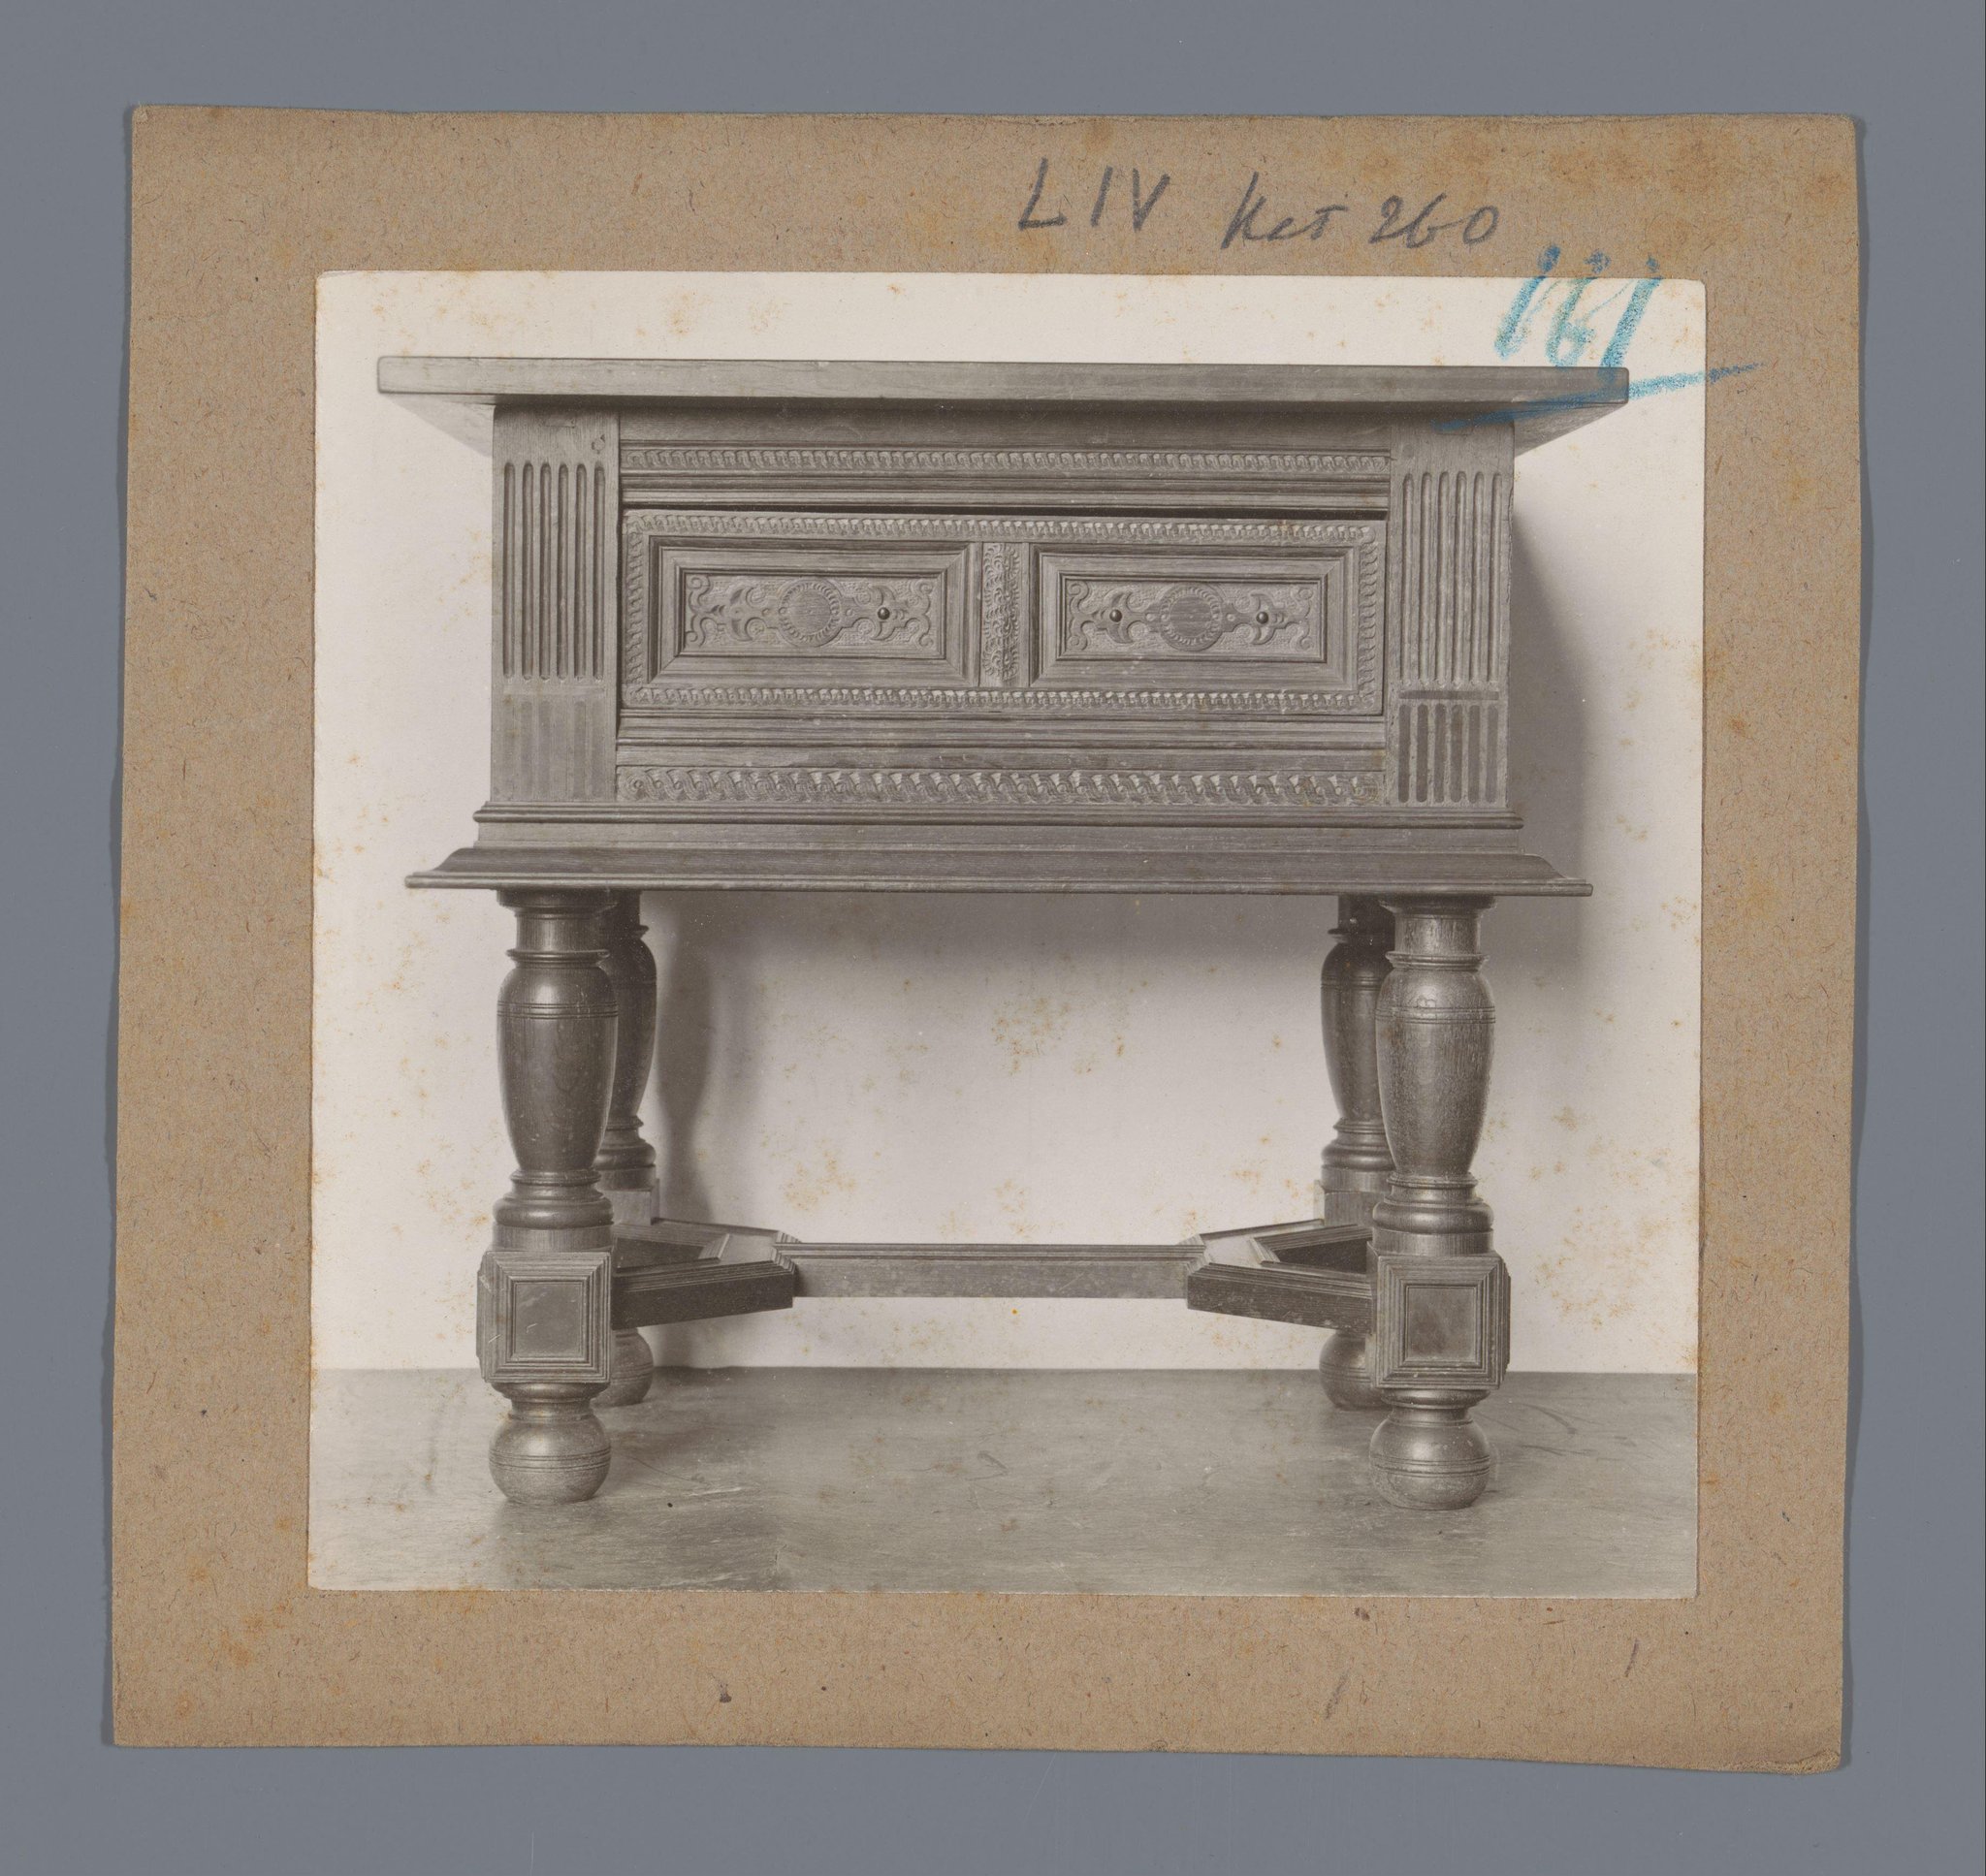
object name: photograph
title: Tafel met een kruis tussen de poten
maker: Anonymous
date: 1875-1900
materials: photographic support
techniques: matte daylight collodion silver print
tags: table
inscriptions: number: ‘LIV Kat 260 161’, collector's mark: ‘Instituut voor kunst-nijverheidsonderwijs Gabriël Metsustraat No. 16, Amsterdam’, collector's mark: ‘Kunstnijverheidschool Quellinus Amsterdam Frans Halsstraat 14.’